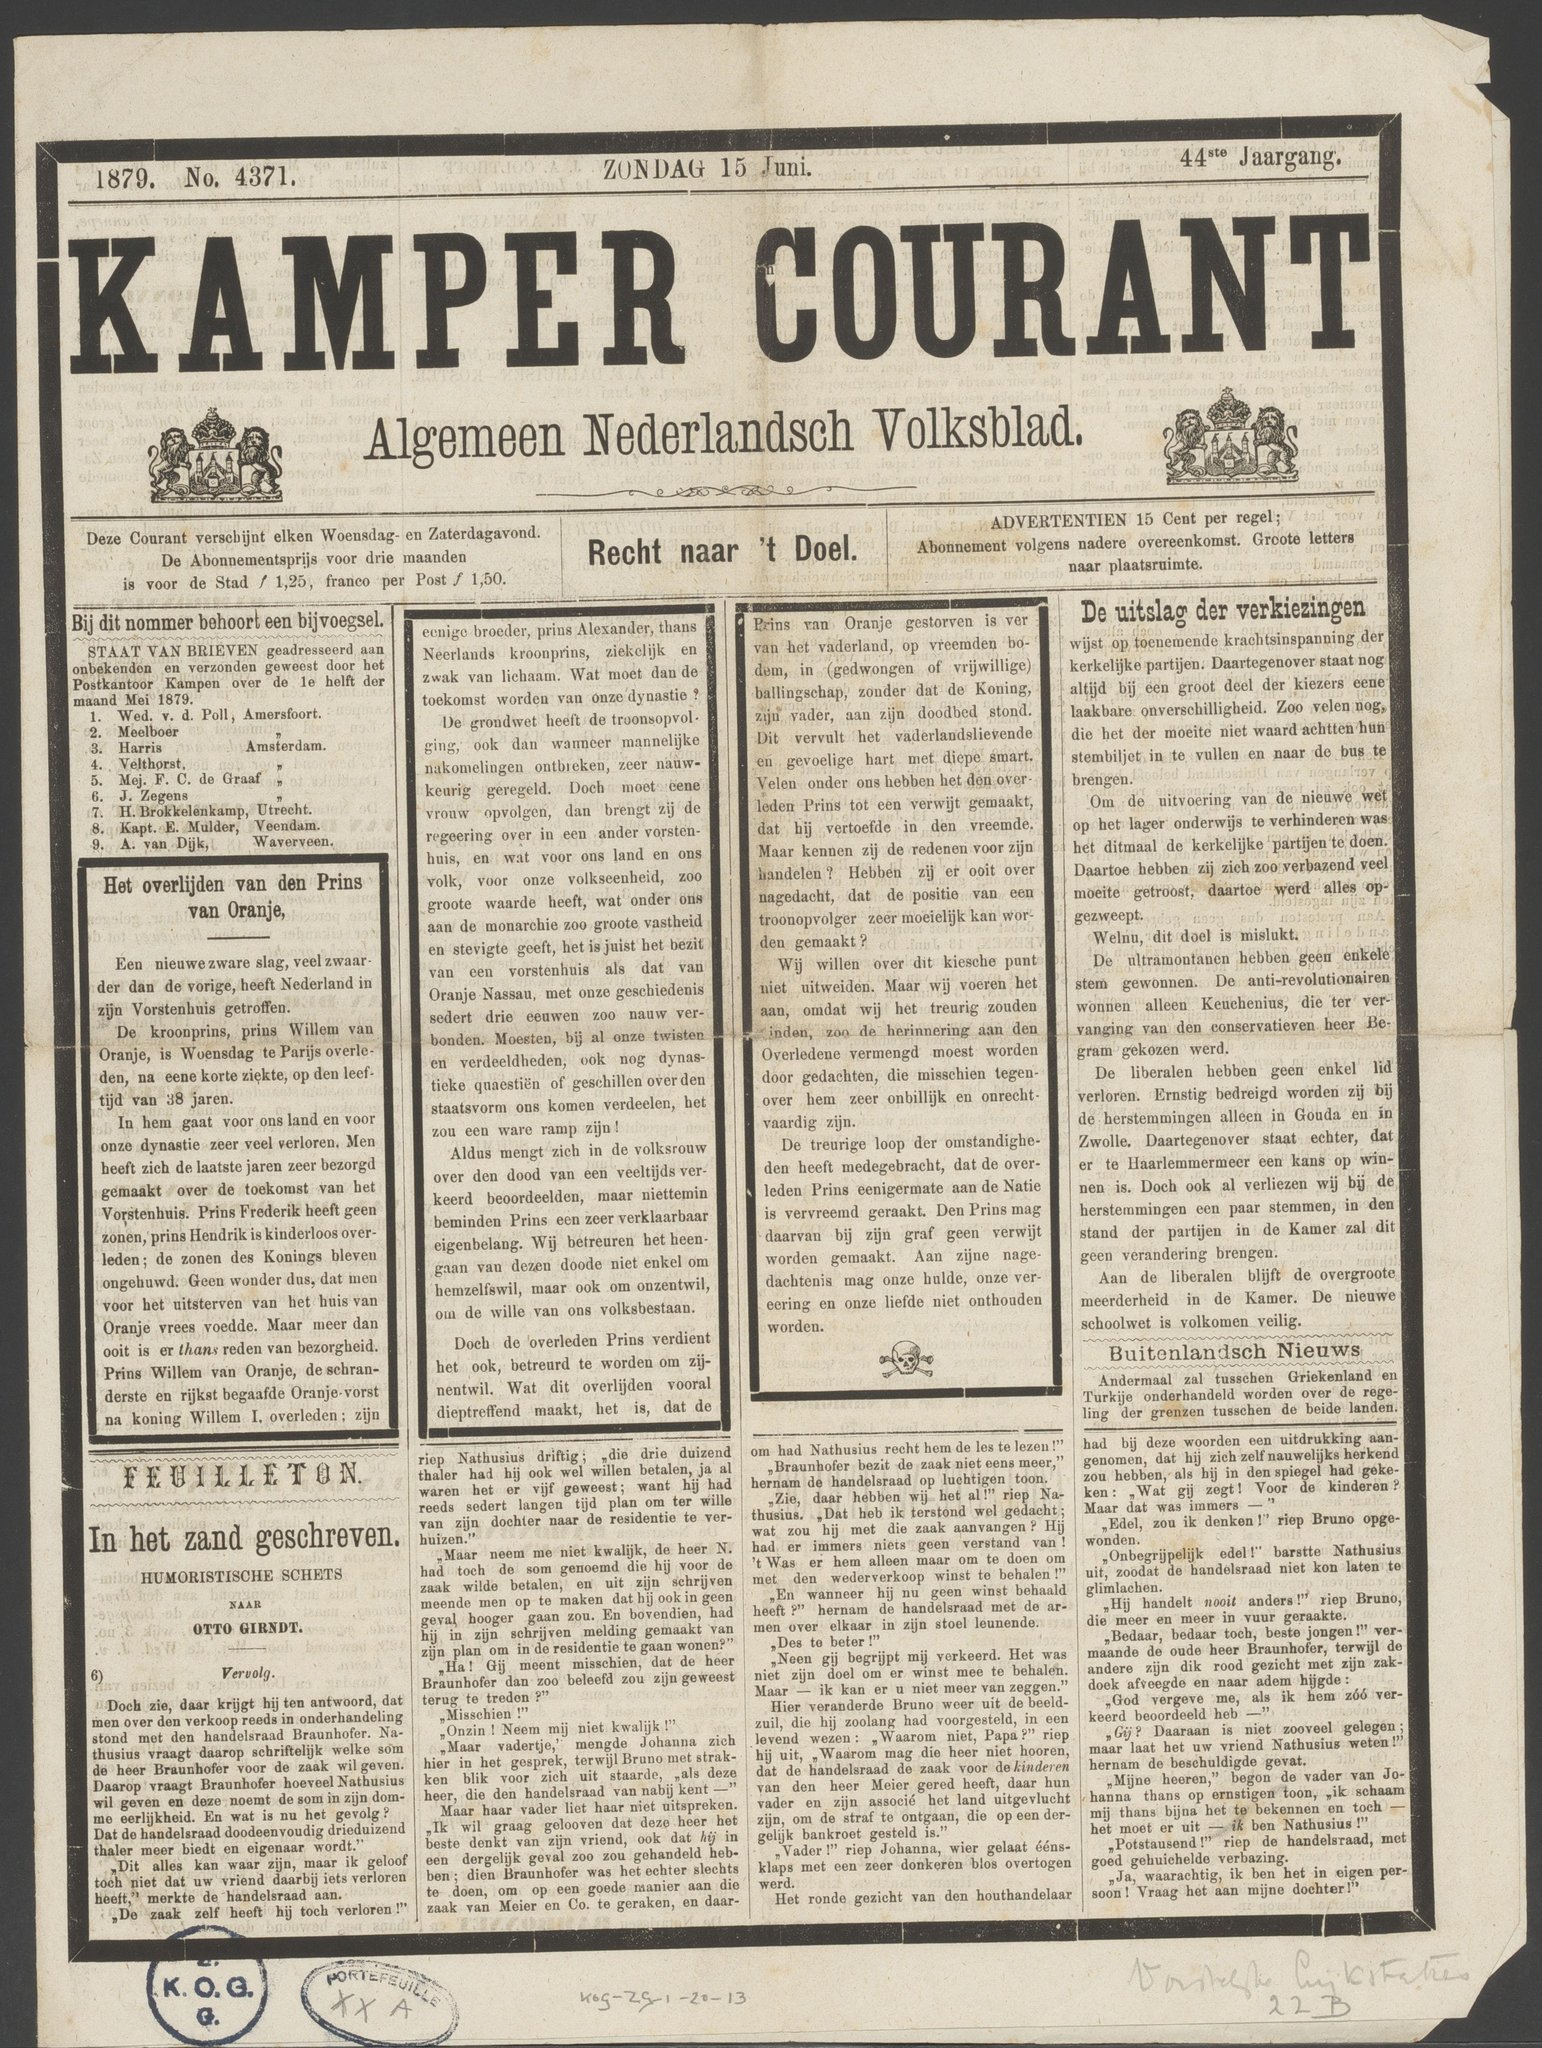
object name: newspaper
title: Kamper Courant, Algemeen Nederlandsch Volksblad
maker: Anonymous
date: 1879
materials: paper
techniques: letterpress printing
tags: hendrik (prins der nederlanden), burial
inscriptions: stamp, collector's mark: Lugt 1641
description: Linksboven genummerd: No. 4371. Onderwerpsrubrieken binnen de Atlas Zeden en Gewoonten: Zeden en Gewoonten in Engeren Zin, Des menschen beging, midden en einde, Vorstelijke lijkstaties.